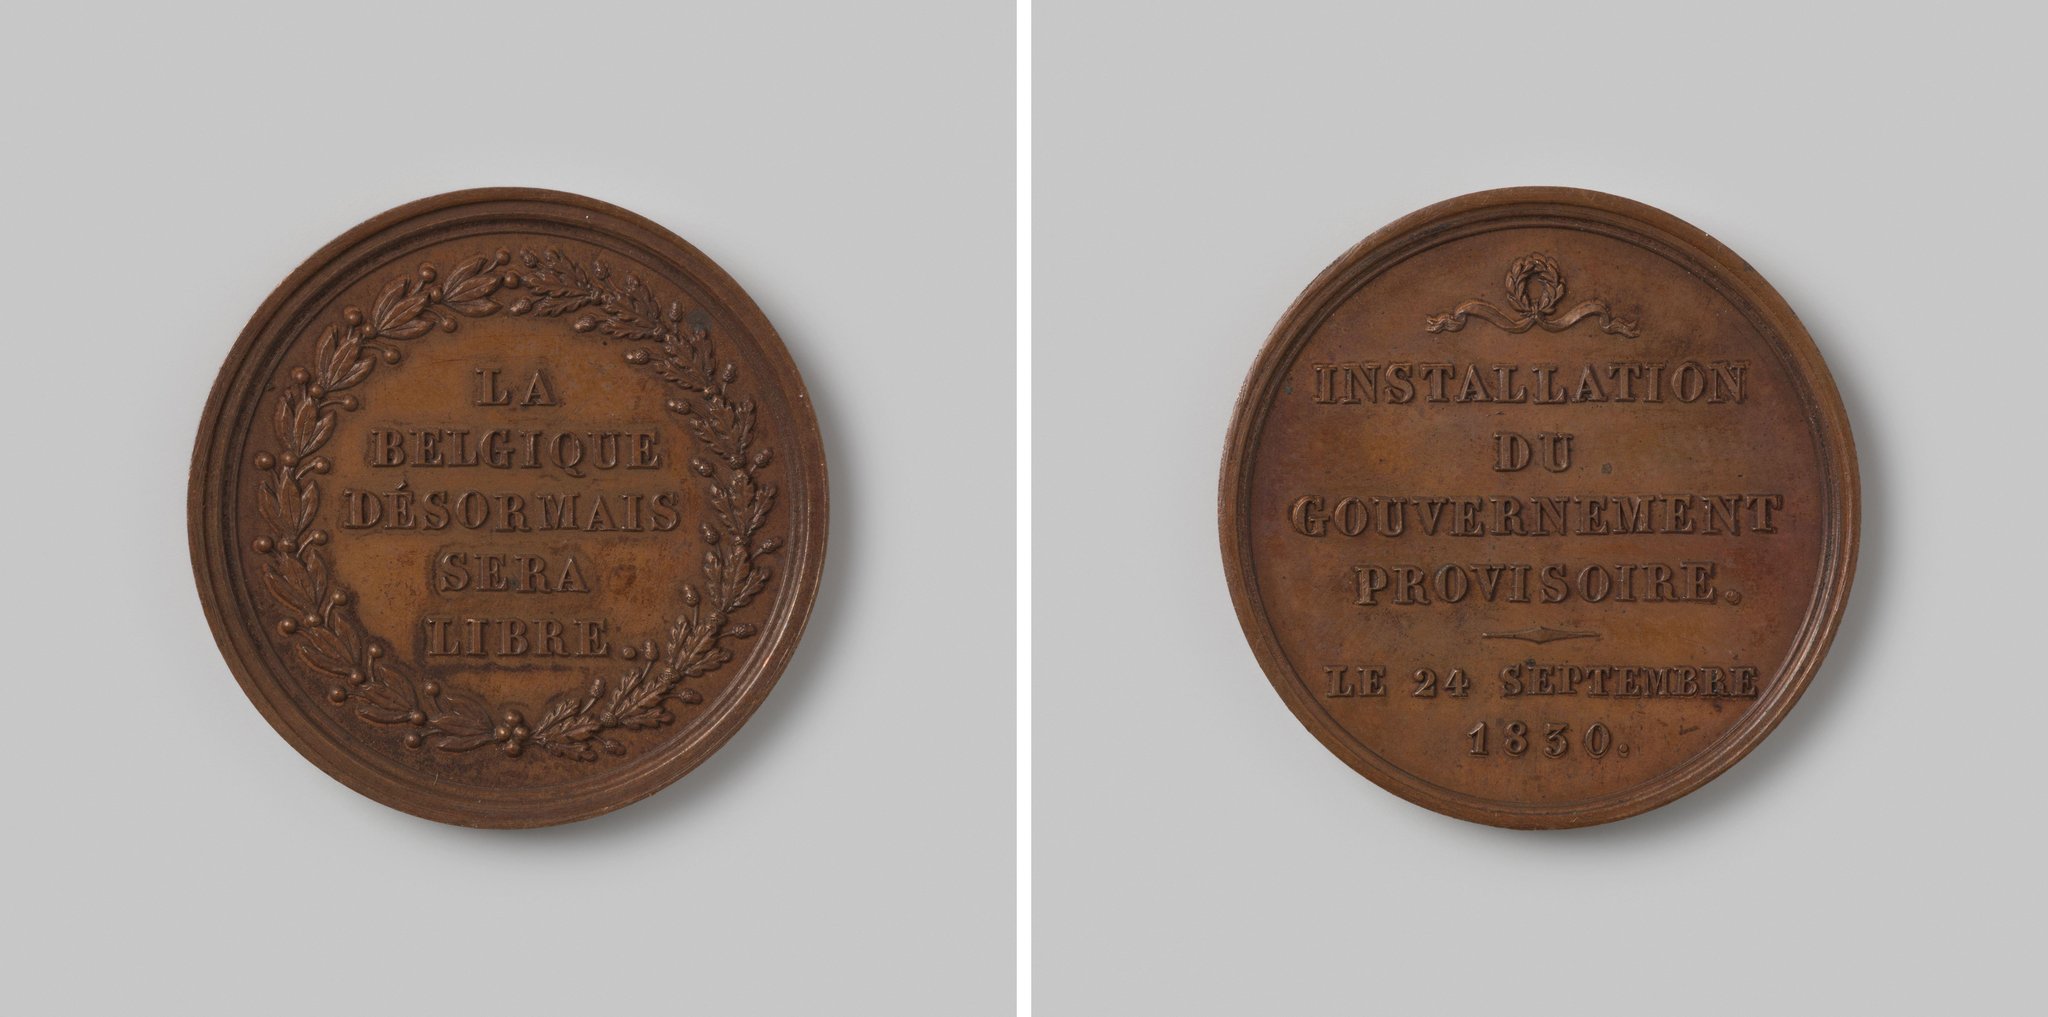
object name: history medal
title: Moedige verdedigers van Brussel 1830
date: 1830-1831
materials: copper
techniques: striking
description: Bronzen penning, op de voorzijde vijf regels tekst tussen een lauwer- en eikentak, op de keerzijde zes regels tekst onder een kleine lauwerkrans.